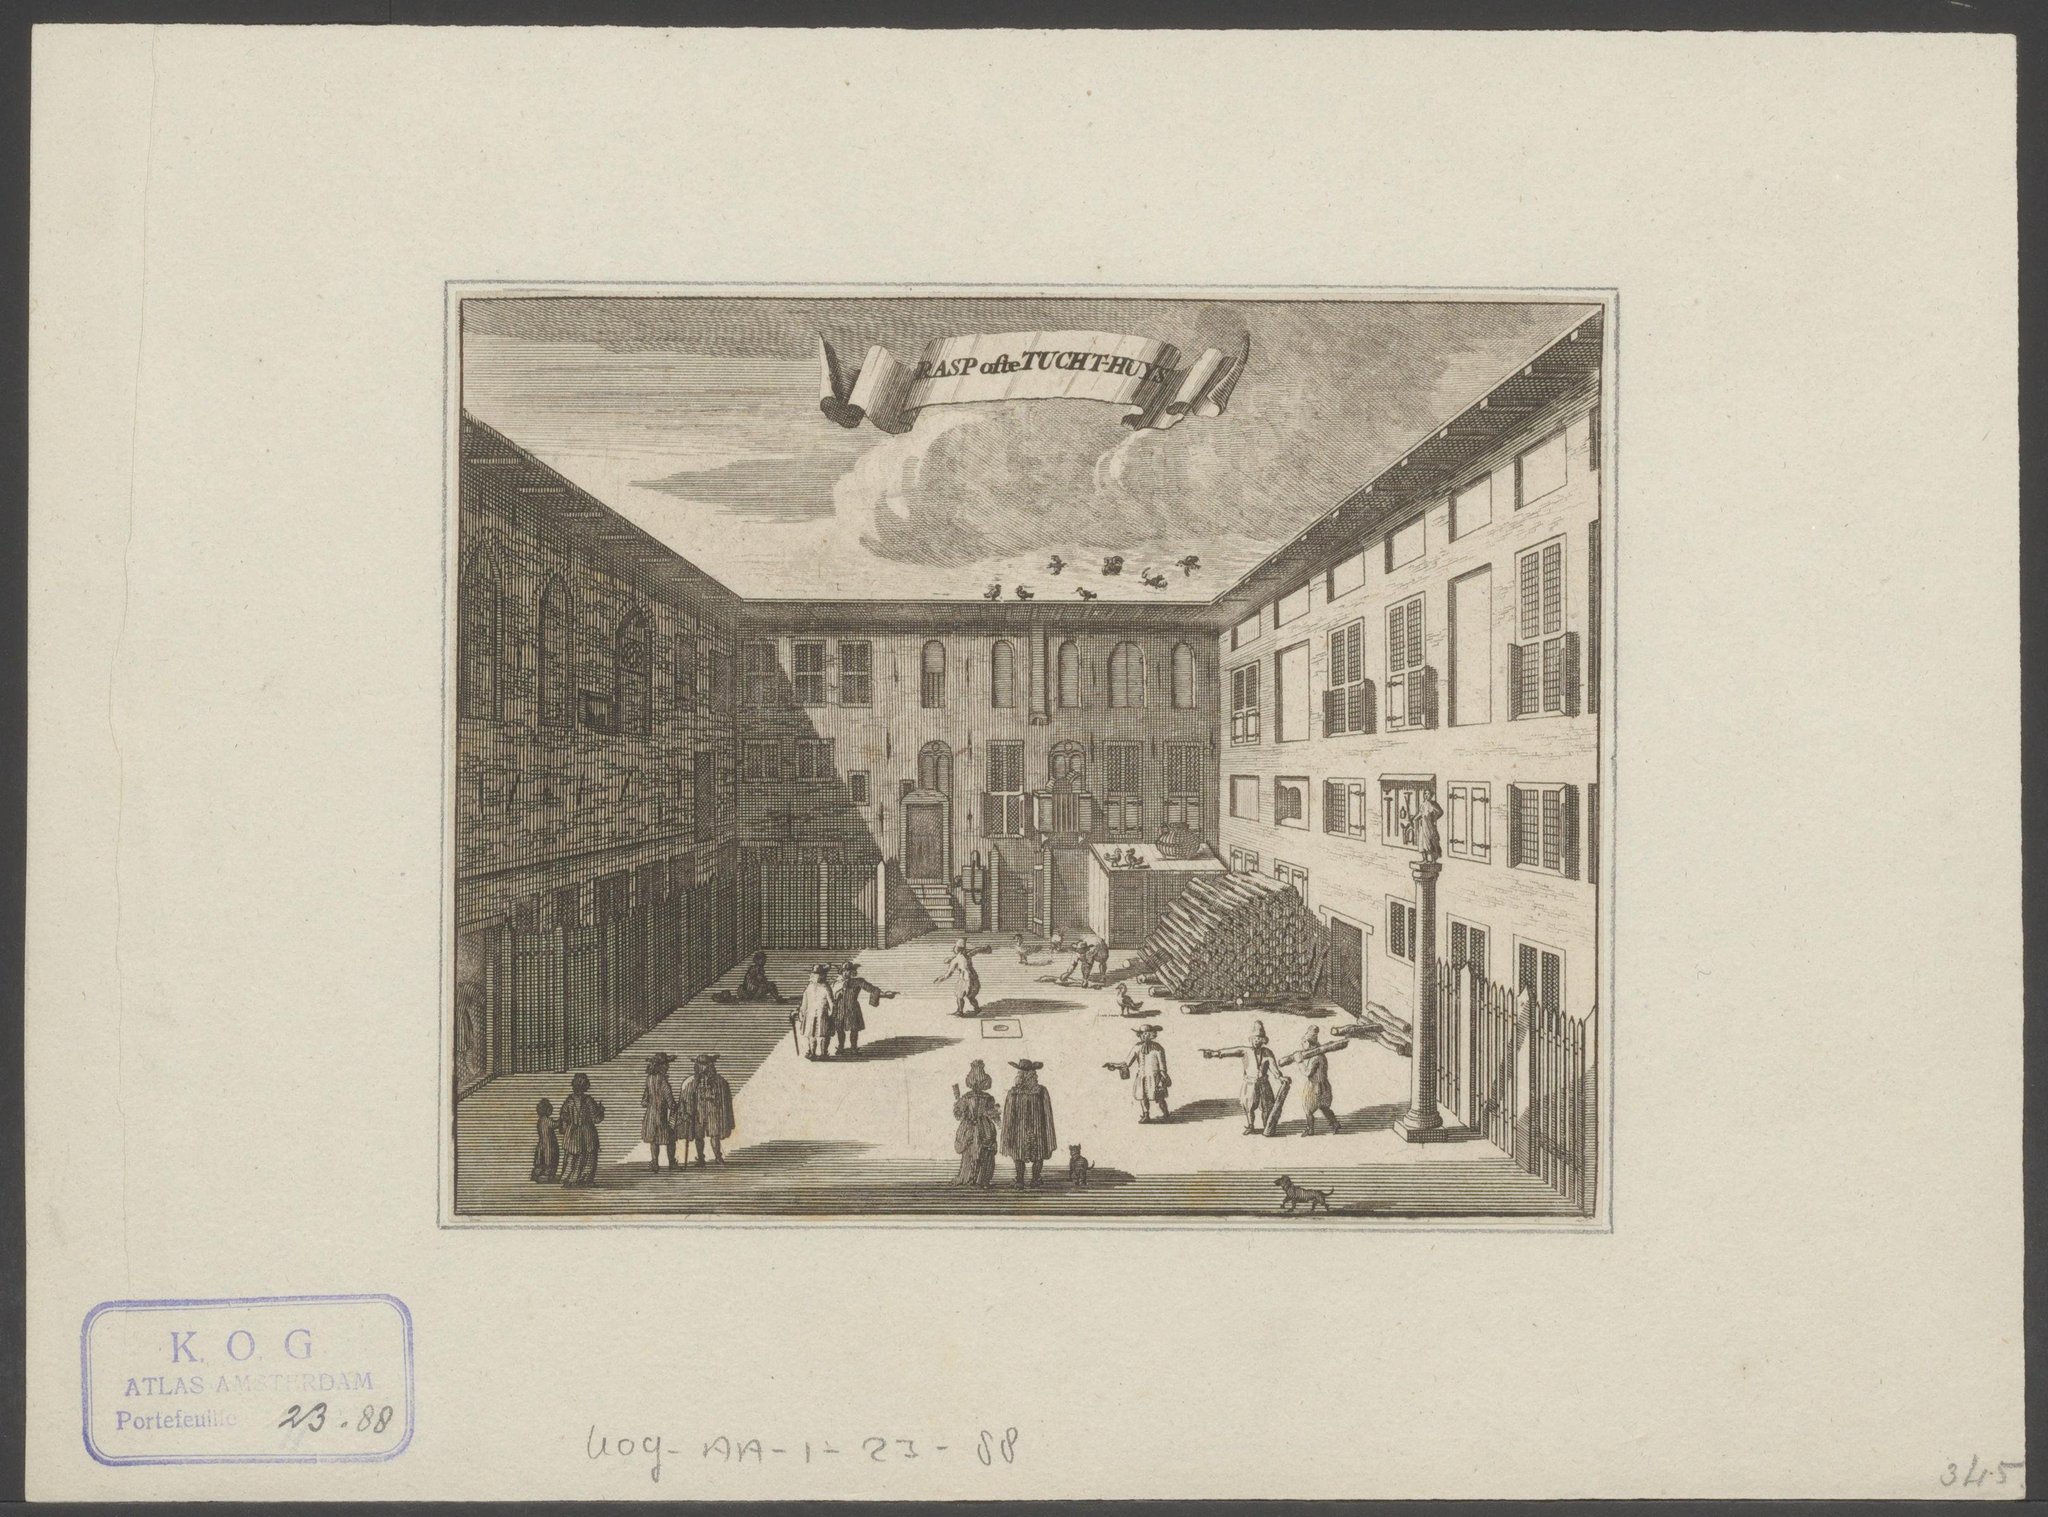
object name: print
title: Rasp ofte Tucht-huys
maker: Anonymous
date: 1726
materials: paper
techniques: etching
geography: northern netherlands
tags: prison, jail, (prisoners) in the prison yard, justitia (justice) as roman personification, workhouse, penal camp, penitentiary, chain gang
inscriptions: collector's mark: Lugt 1641b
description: Huidige staat van prent ook gebruikt in: Commelin, Casparus. Beschryvinge van Amsterdam (…). 2de druk. Amsterdam: Andries van Damme, Johannes Ratelband, weduwe Antony van Aeltwijk en Hermanus Uytwerf, 1726, dl. 1, p. 509. Eerdere staat van prent ook gebruikt in: Commelin, Casparus. Beschryvinge van Amsterdam (…). Amsterdam: Abraham Wolfgang, Gillis Janssonius van Waesberge of Johannes Janssonius van Waesberge, Hendrick Boom of weduwe Dirk Boom, Abraham van Sanderen en Rembertus Goethals, 1693, dl. 1, p. 509. En in: Commelin, Casparus. Beschryvinge van Amsterdam (…). Amsterdam: weduwe Aart Dircksz Oossaan, 1694, dl. 1, p. 509.